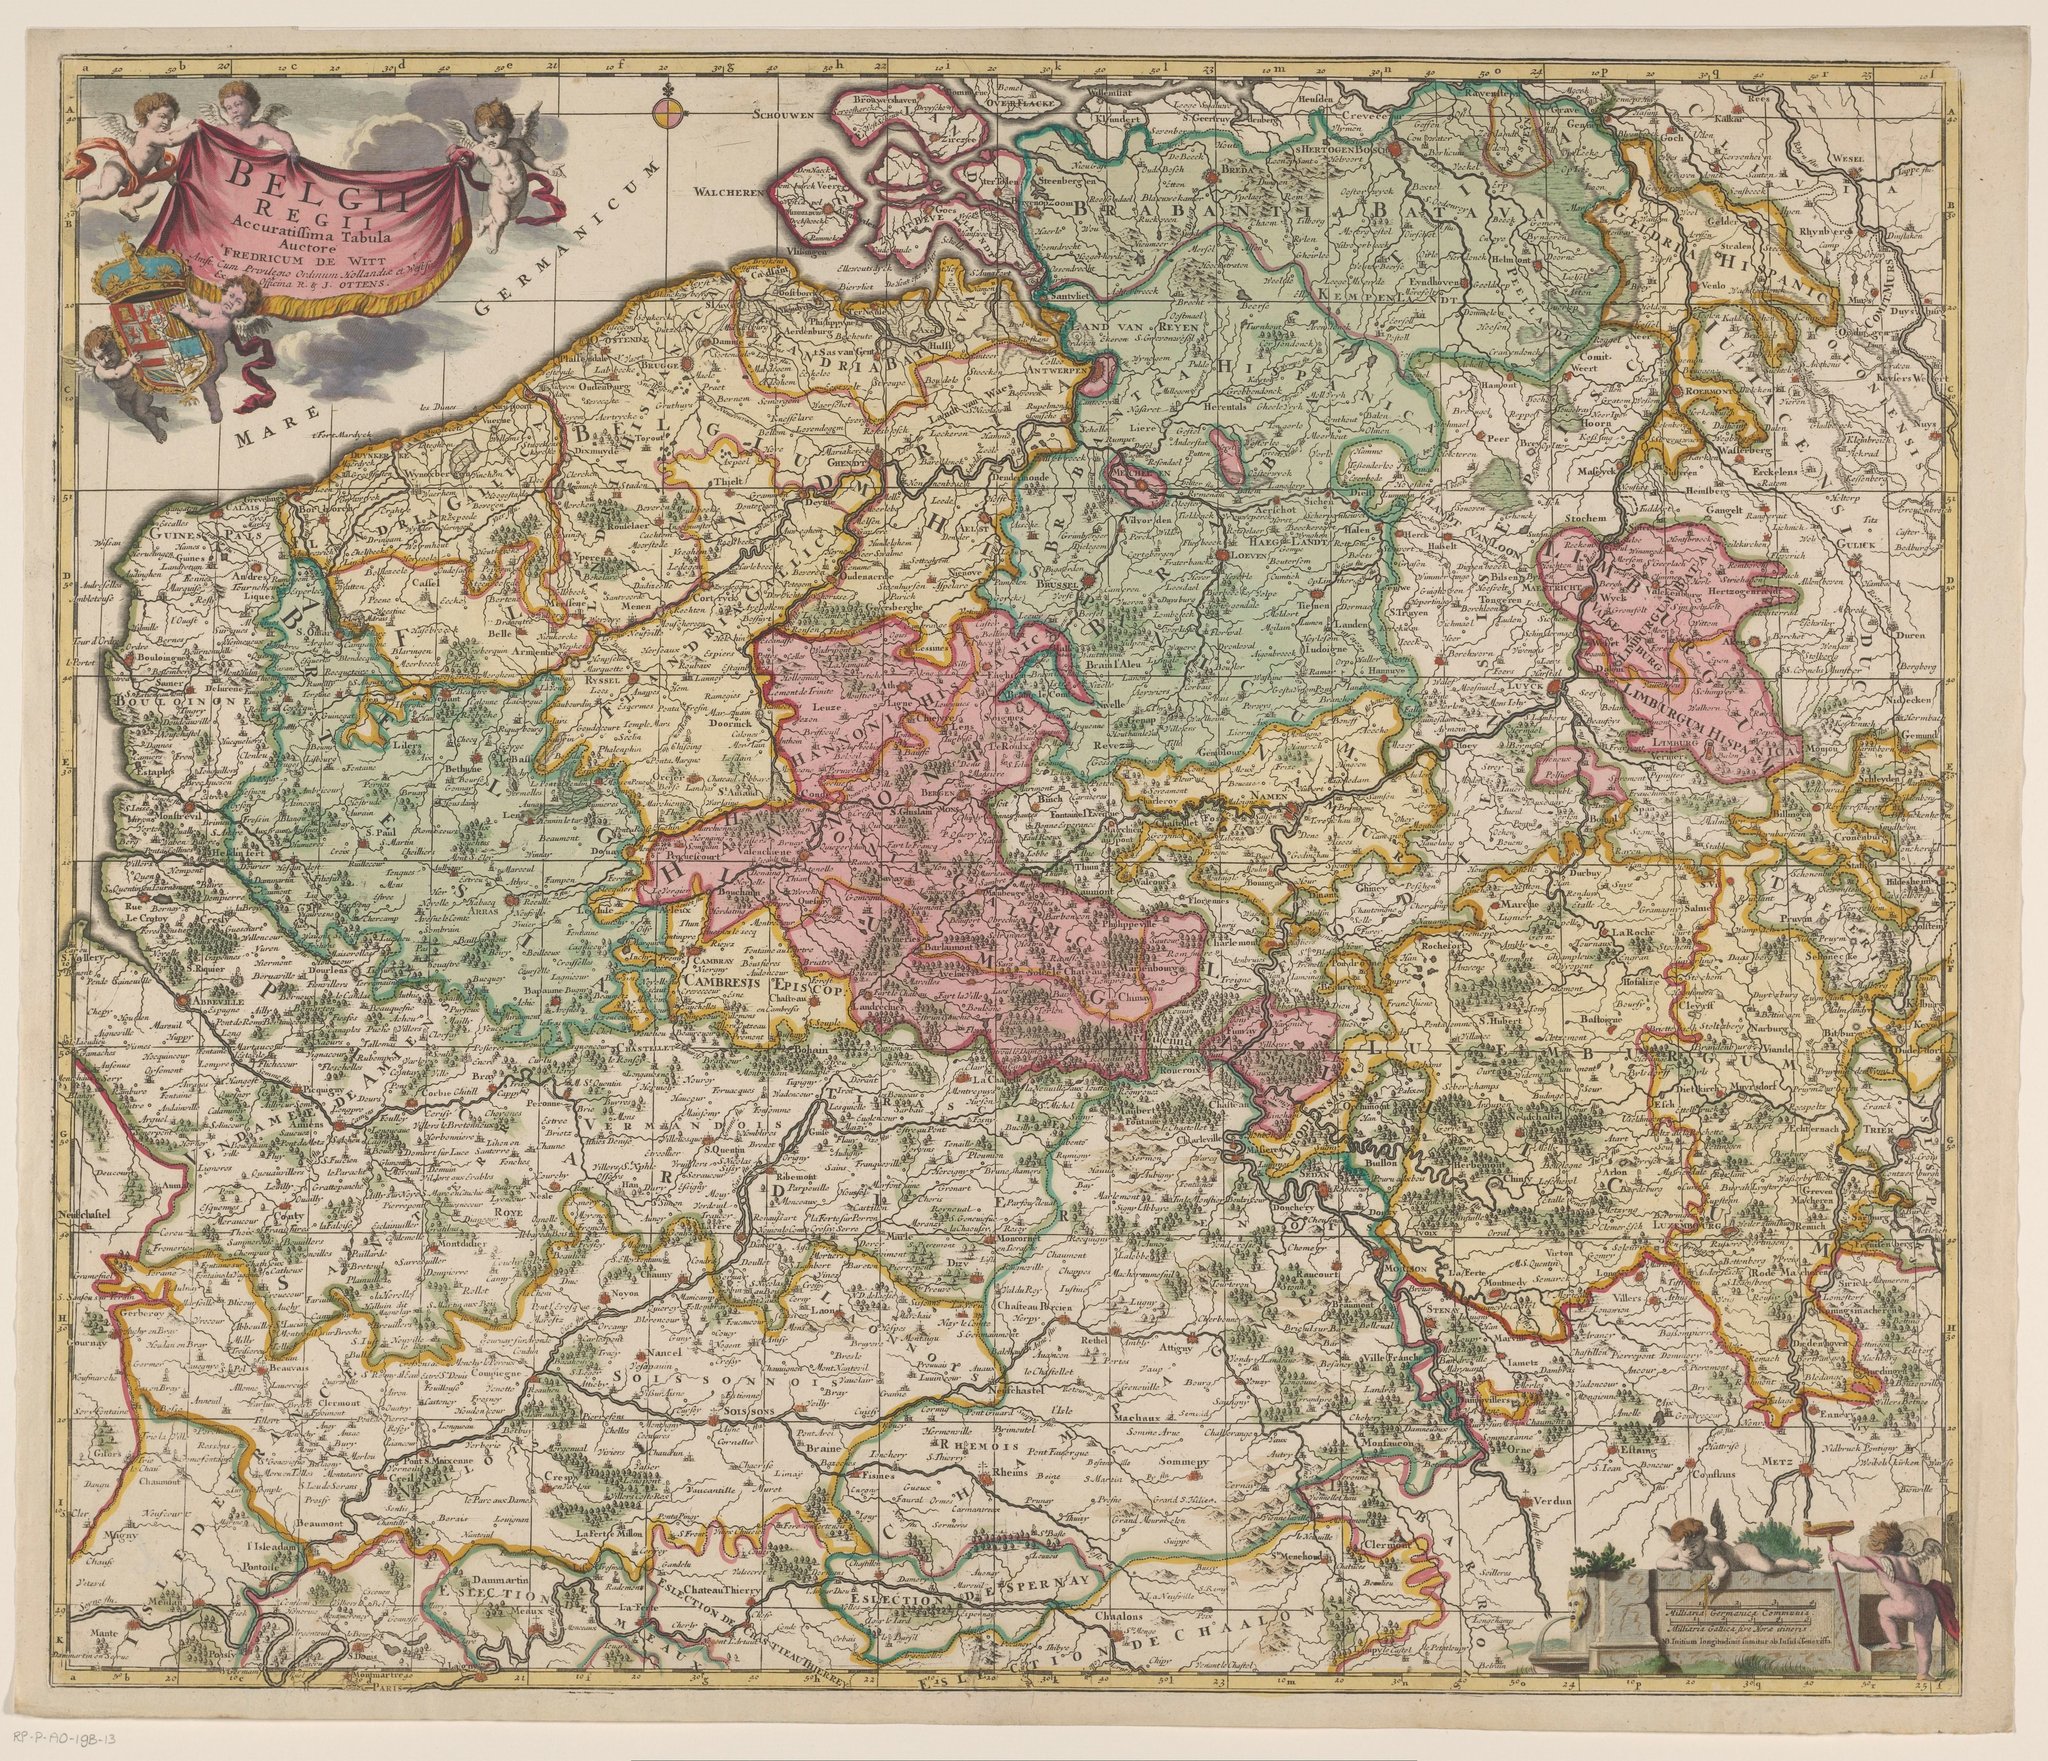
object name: print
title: Belgii regii accuratissima tabula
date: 1726-1750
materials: paper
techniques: engraving, hand coloring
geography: amsterdam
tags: maps of separate countries or regions, armorial bearing, heraldry, southern netherlands, belgium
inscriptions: collector's mark: Lugt 2228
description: Kaart van de Zuidelijke Nederlanden. Linksboven de titelcartouche met daaromheen vijf putti, waarvan twee het wapen van de koning van Spanje dragen. Rechtsonder een cartouche met twee schaalstokken: 4 Milliaria Germanica Communia / 5 Milliaria Gallica sive Horae itineris. De kaart is voorzien van een zoekrooster en een gradenverdeling langs de randen.